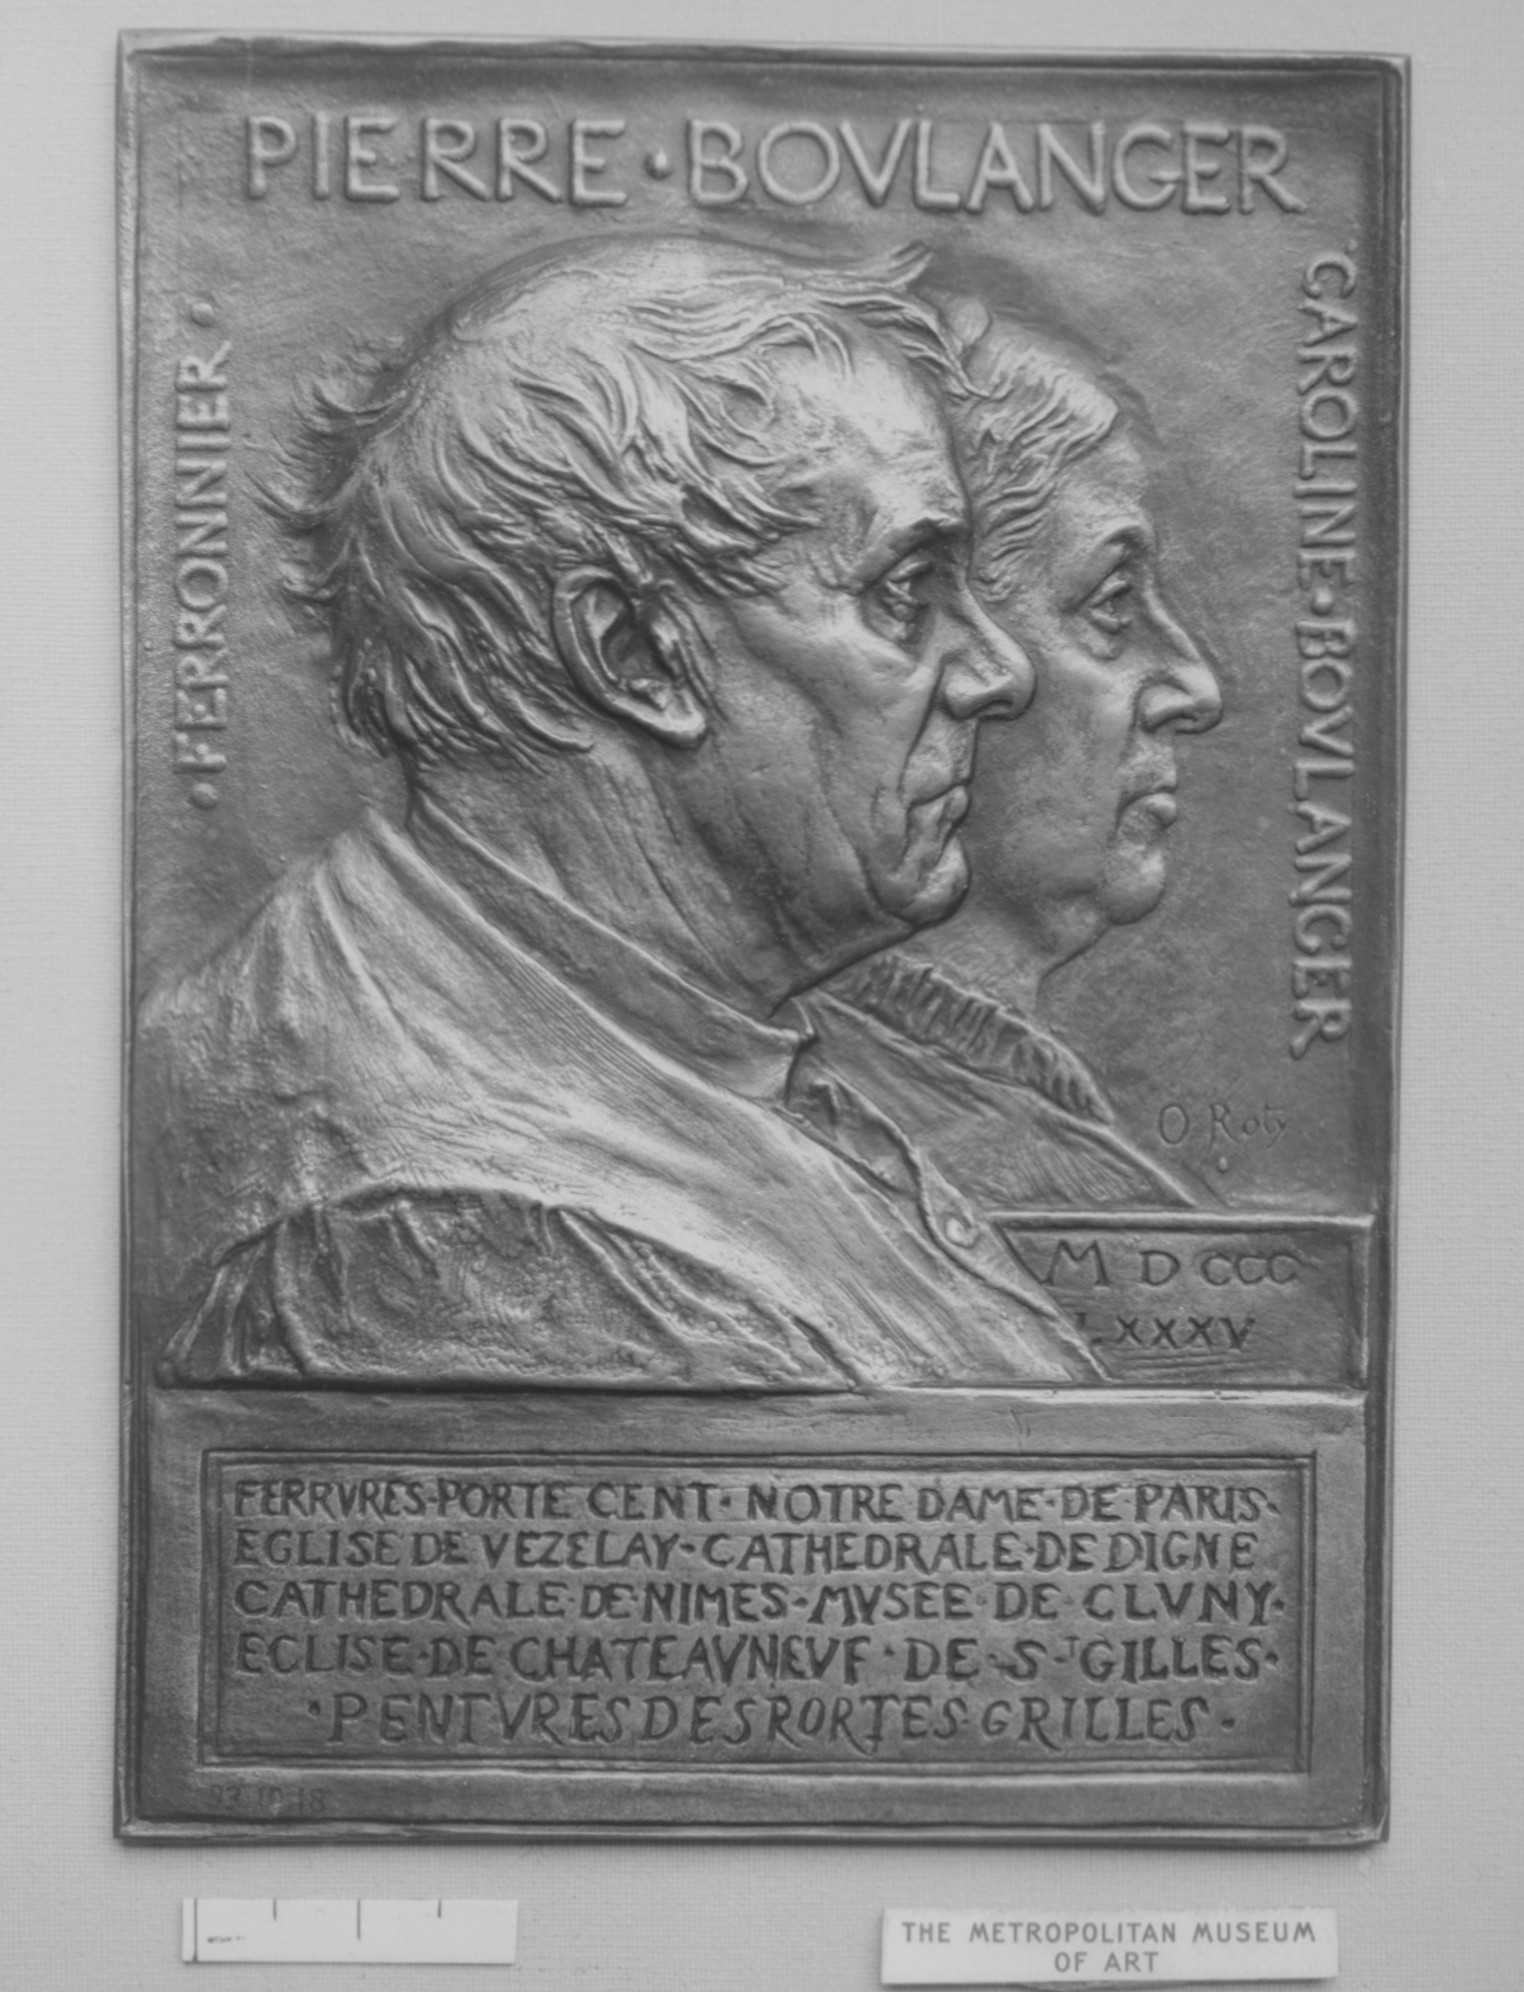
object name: plaque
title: Pierre Boulanger, Ironworker, and His Wife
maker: louis-oscar roty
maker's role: artist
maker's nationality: french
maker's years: 1846-1911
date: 1801-1900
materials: bronze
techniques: casting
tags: men,profiles,women